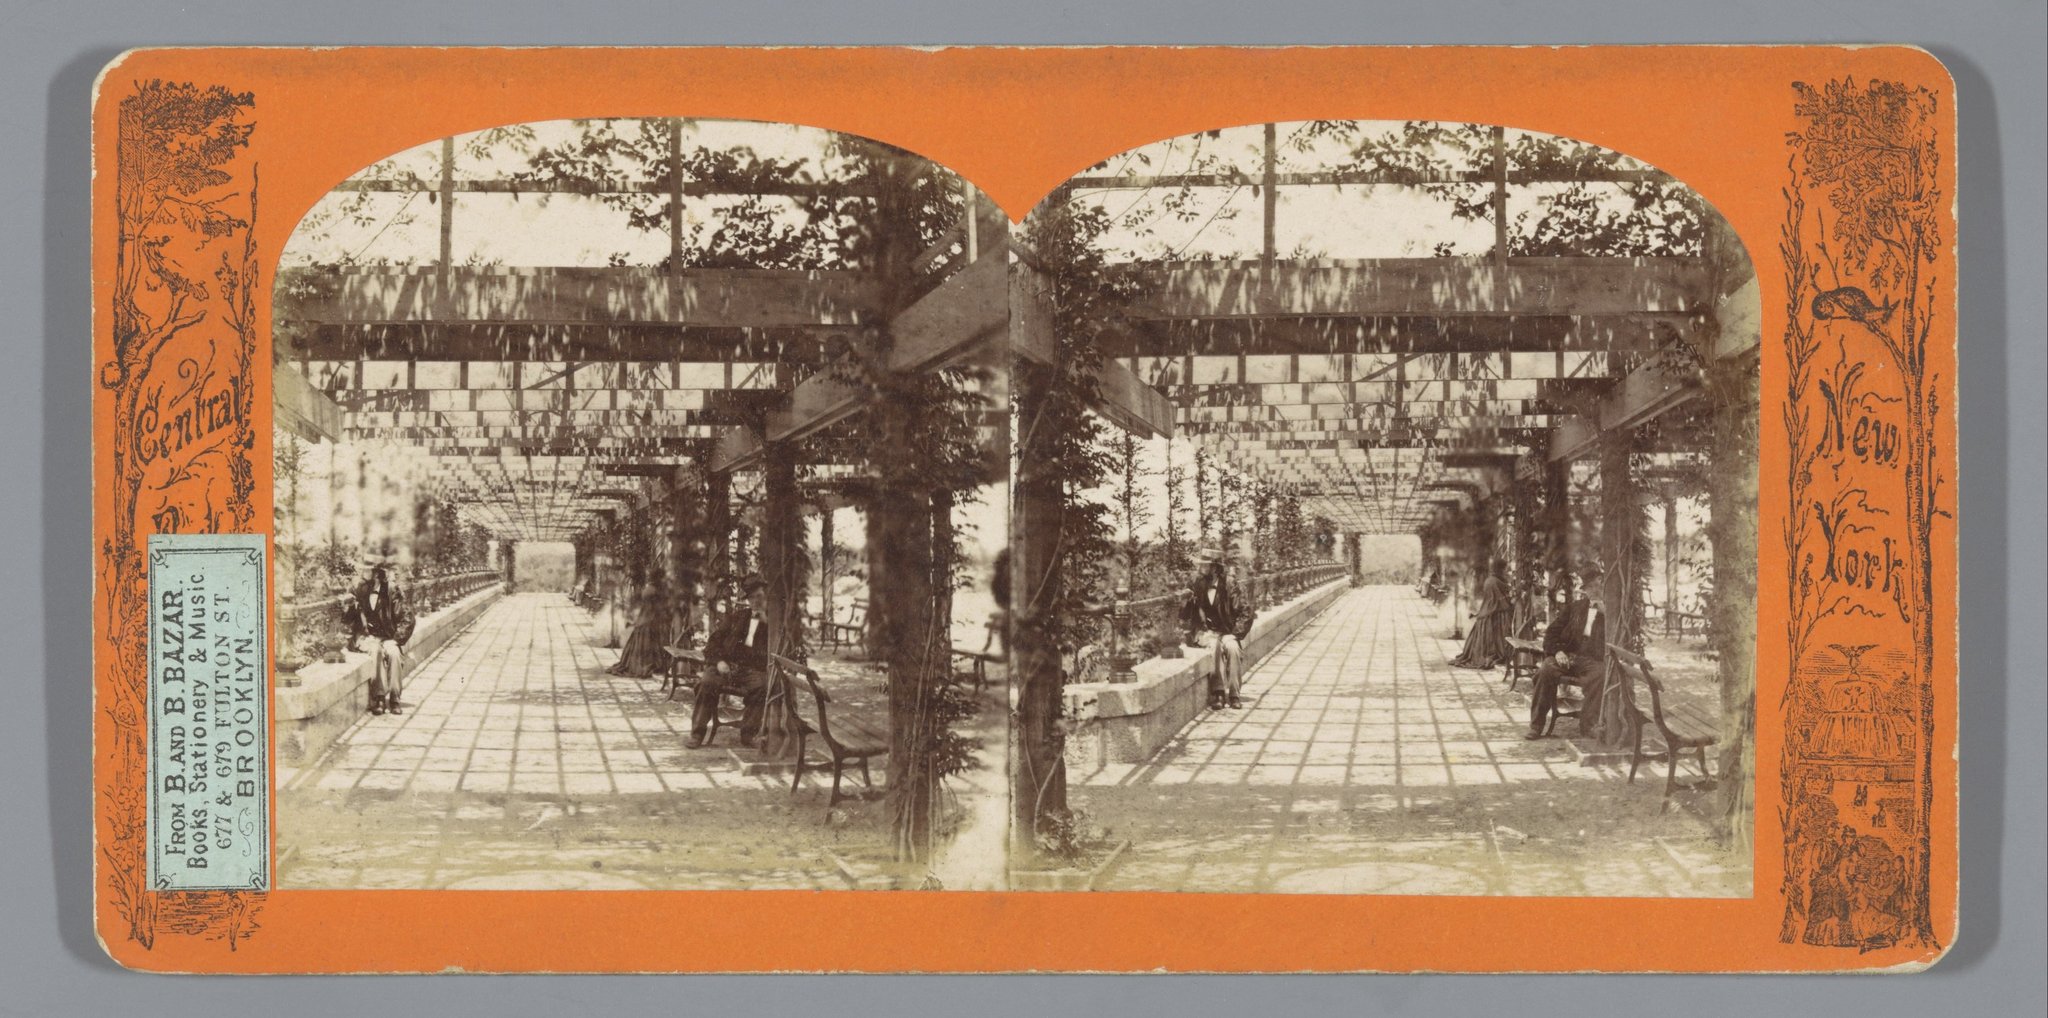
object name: stereograph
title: Central Park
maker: Anonymous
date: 1868-1890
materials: cardboard, paper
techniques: albumen print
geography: central park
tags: vine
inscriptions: inscription: ‘THE MUSEUM./ BOW BRIDGE./ THE VINE CLAD ARBOR. (...)’, retailer's mark: ‘From B. and B. Bazar./ Books, Stationary & Music./ 677 & 679 FULTON ST./ BROOKLYN.’